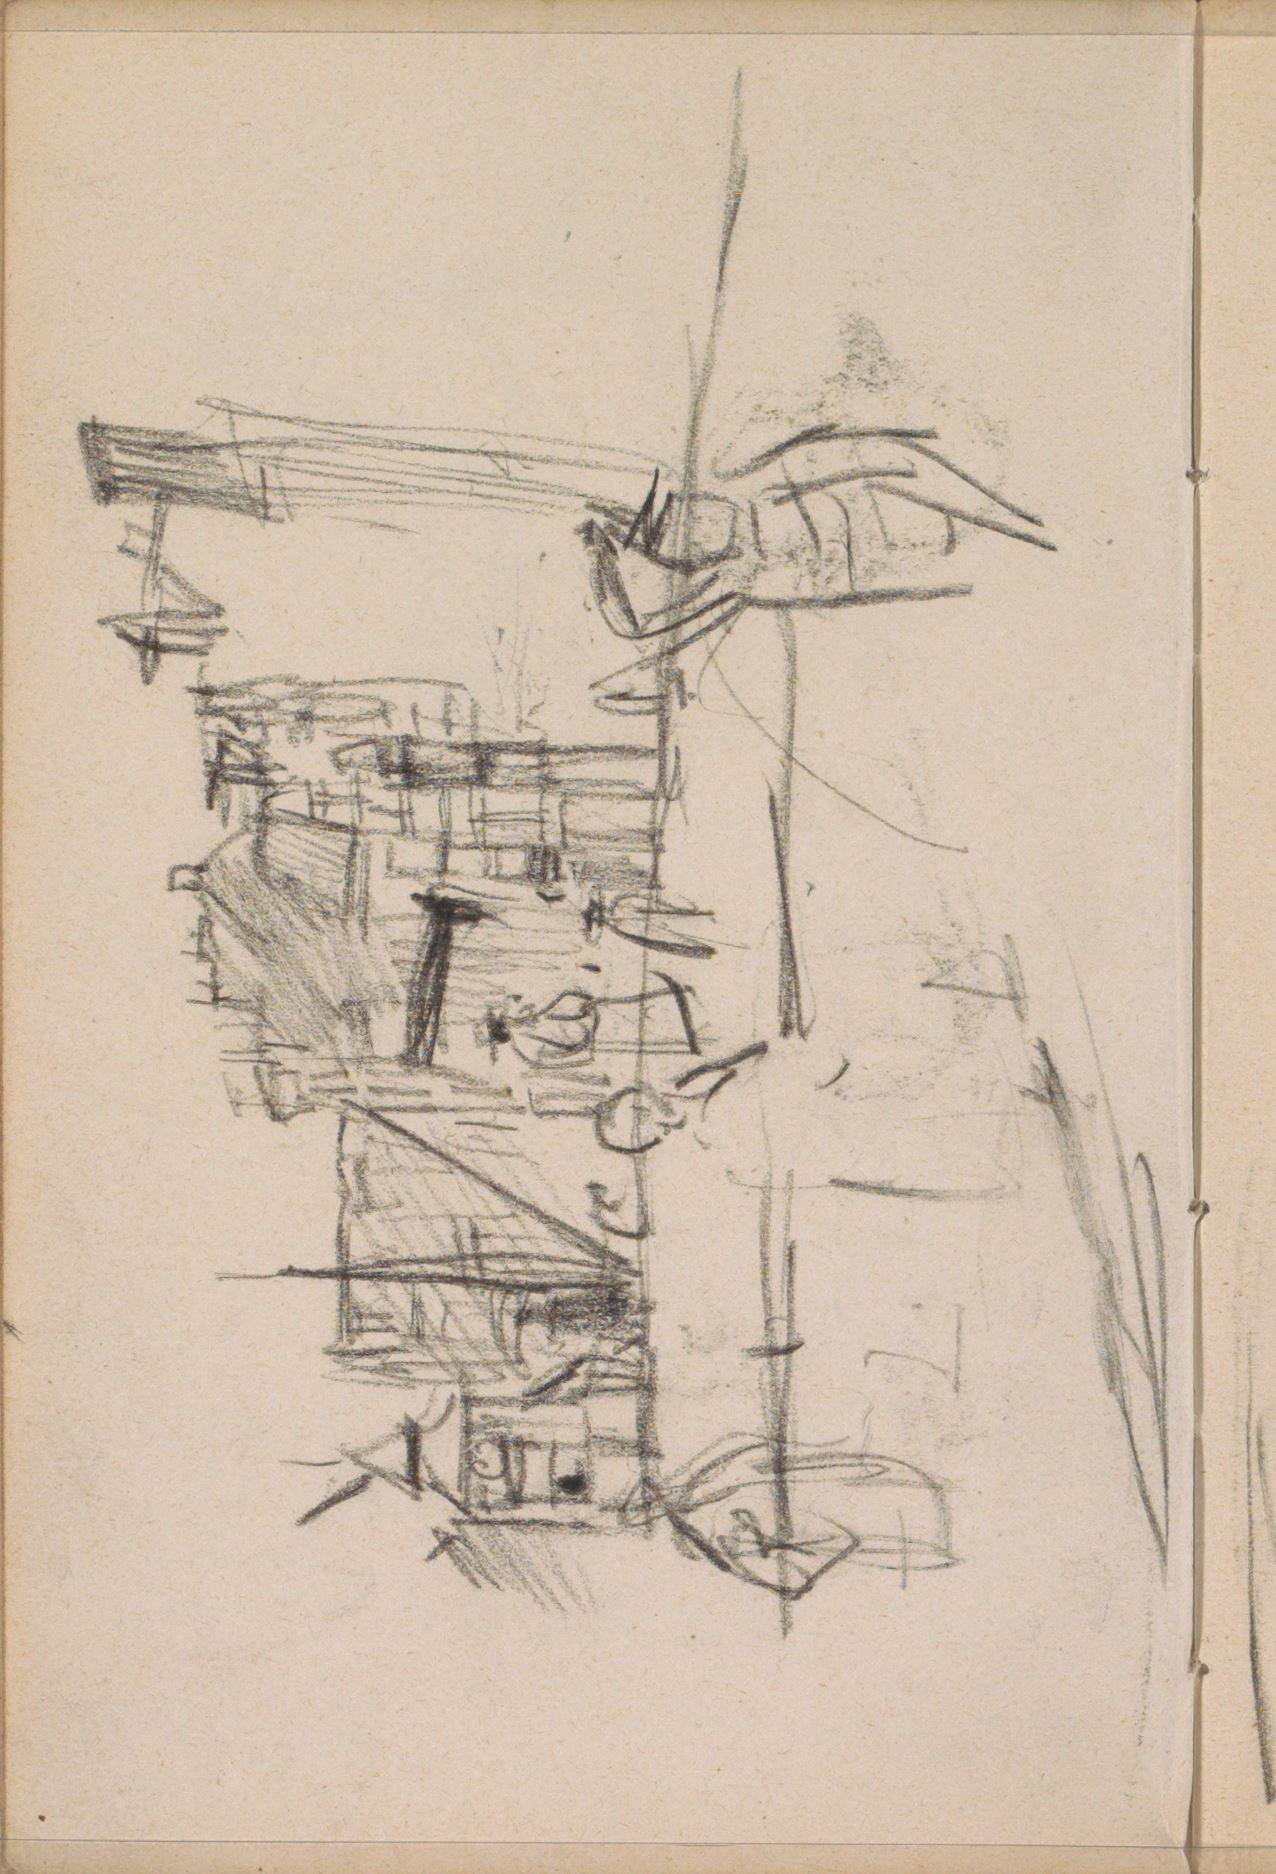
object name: sketchbook leaf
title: Gezicht op een plein, mogelijk het Muntplein in Amsterdam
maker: george hendrik breitner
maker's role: draughtsman, painter, print maker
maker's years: 1857-1923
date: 1900-1923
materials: chalk, paper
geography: amsterdam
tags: urban housing, square, place, circus, etc. (+ city(-scape) with figures, staffage)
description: Pagina 15 uit een schetsboek met 39 bladen.